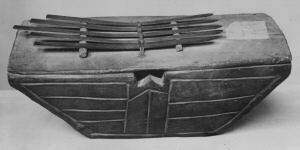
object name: zanze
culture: fan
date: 1867-1900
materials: wood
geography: benin